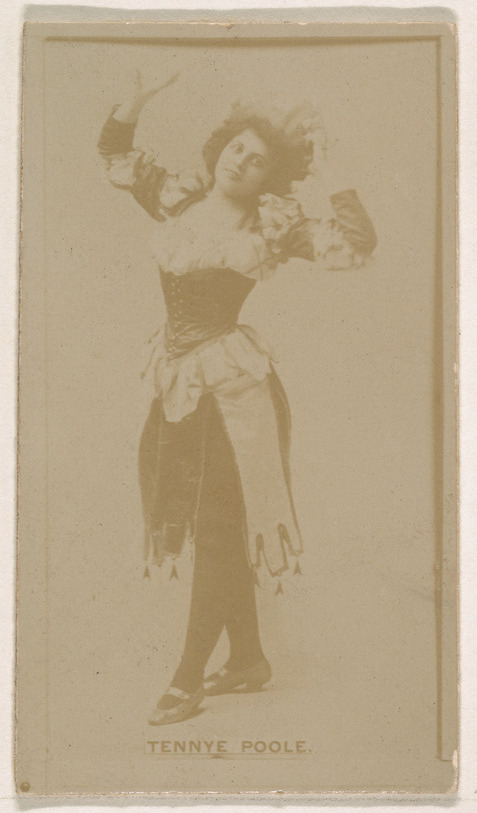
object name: photograph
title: Tennye Poole, from the Actresses series (N245) issued by Kinney Brothers to promote Sweet Caporal Cigarettes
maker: kinney brothers tobacco company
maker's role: publisher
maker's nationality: american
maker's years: 1869-2011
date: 1890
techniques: albumen silver print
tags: portraits,women,actresses